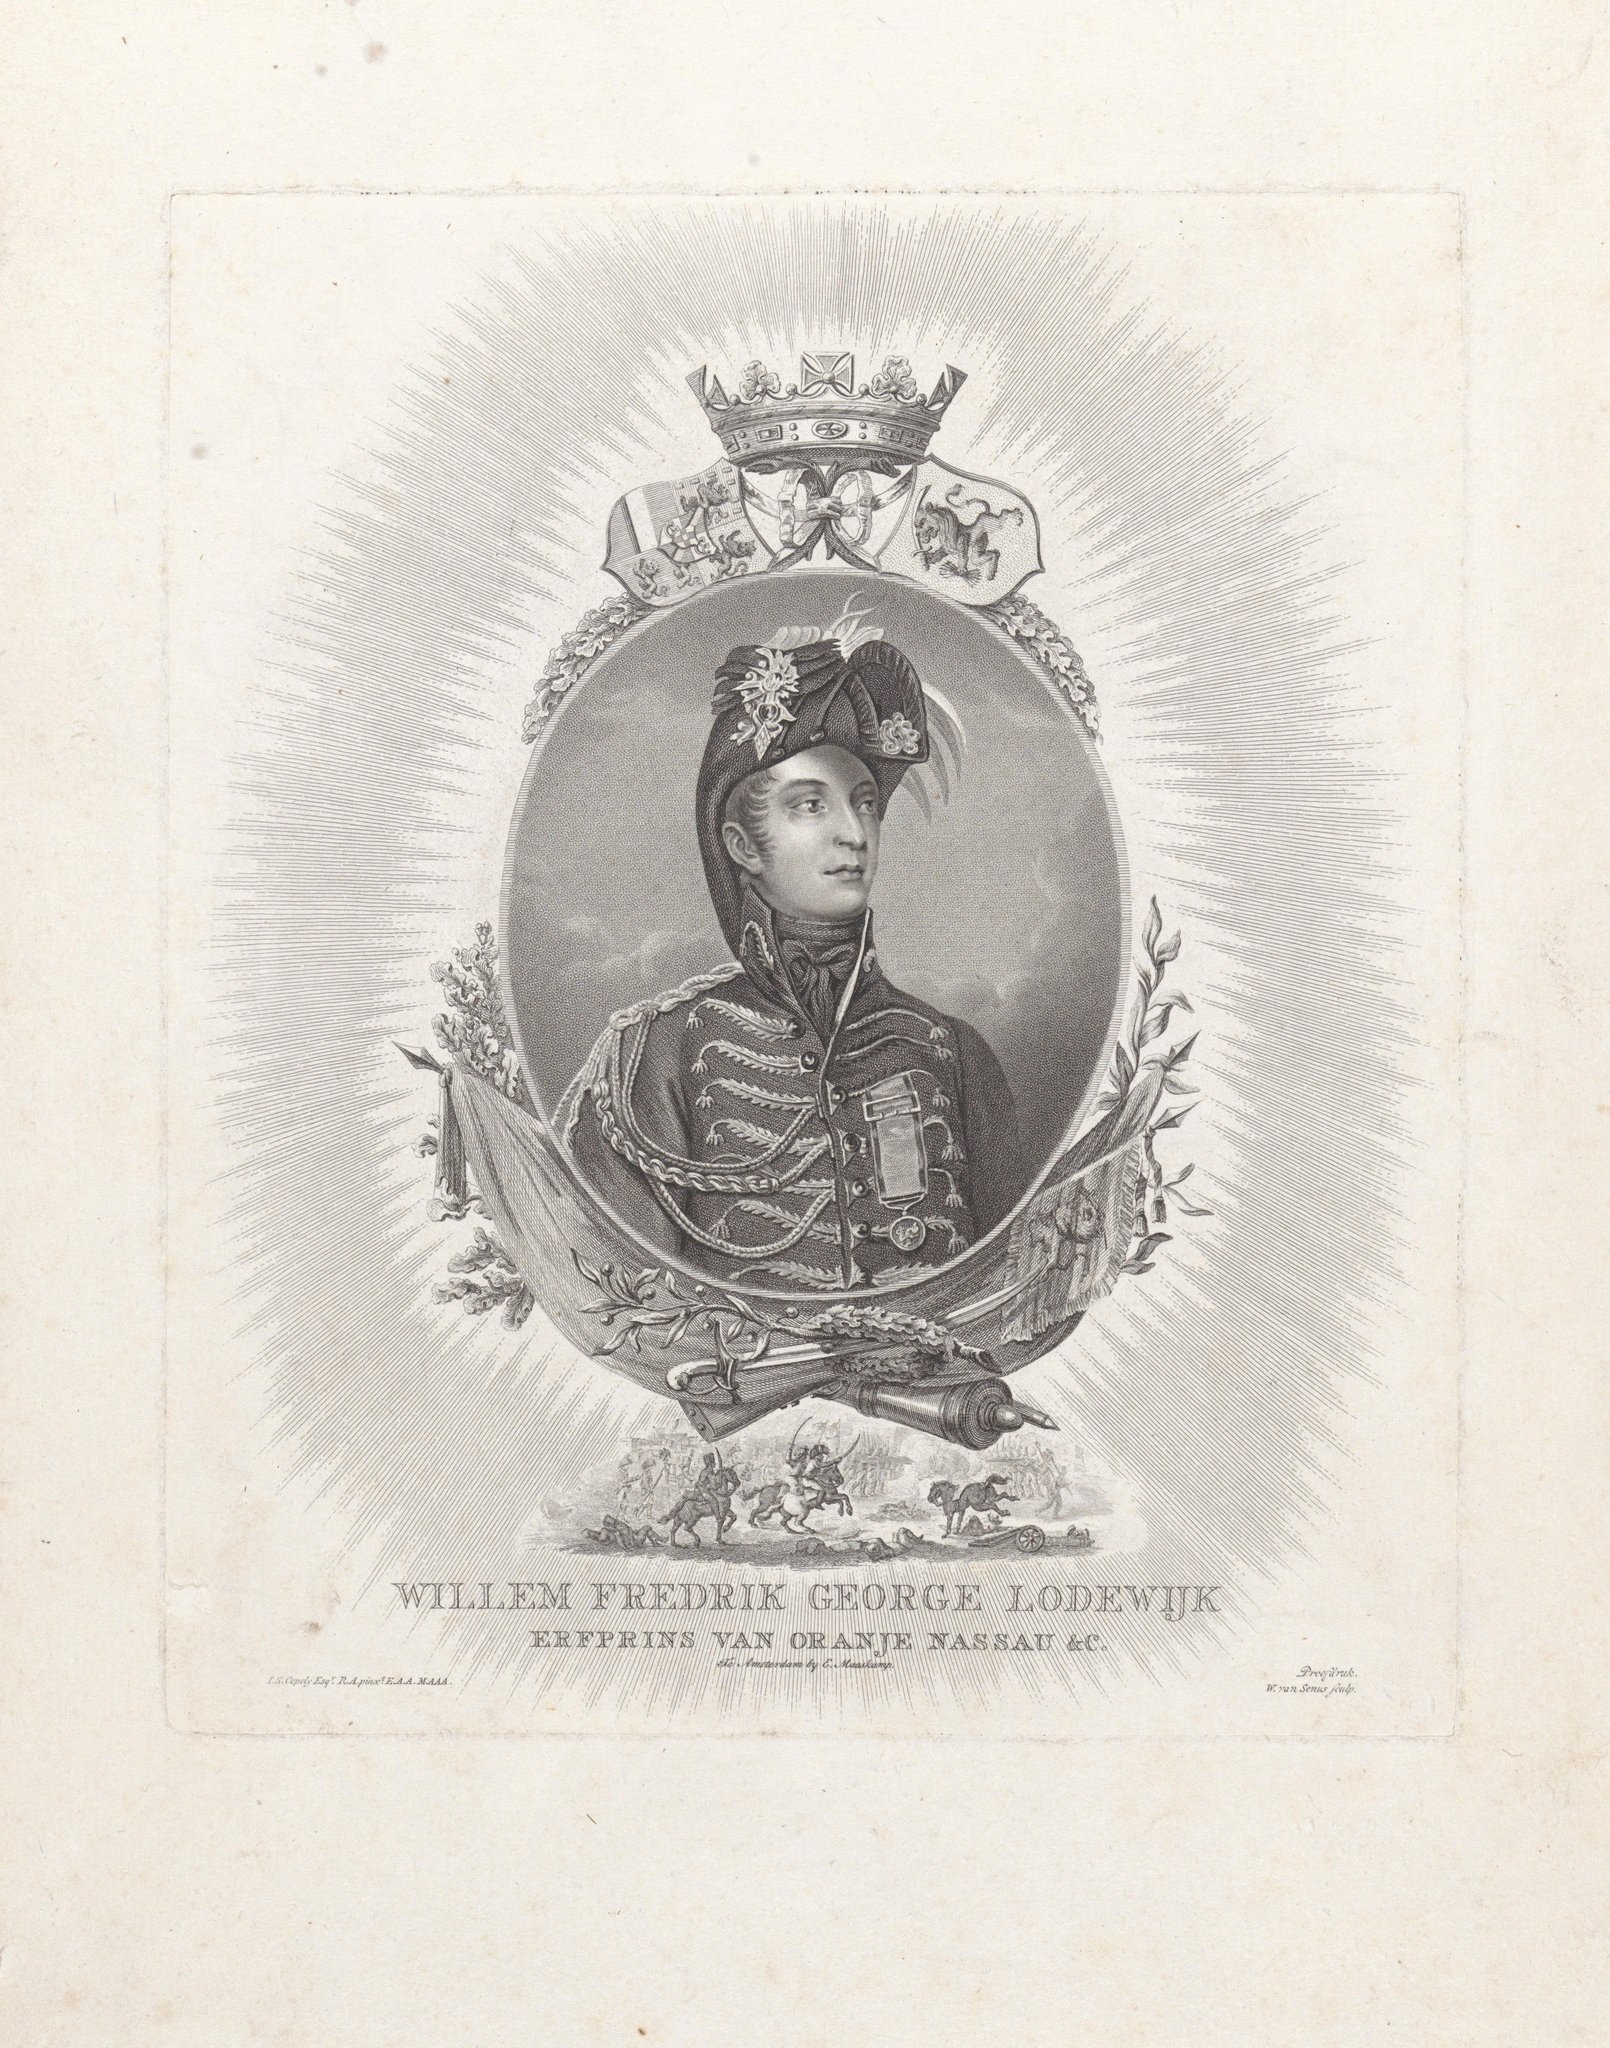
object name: print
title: Portret van Willem II (koning der Nederlanden)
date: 1815-1840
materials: paper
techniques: engraving, etching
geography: amsterdam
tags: the hague, william ii of the netherlands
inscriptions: collector's mark: Lugt 2228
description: Portret van Willem II (koning der Nederlanden), in een stralenkrans, met onder het portret een veldslag.